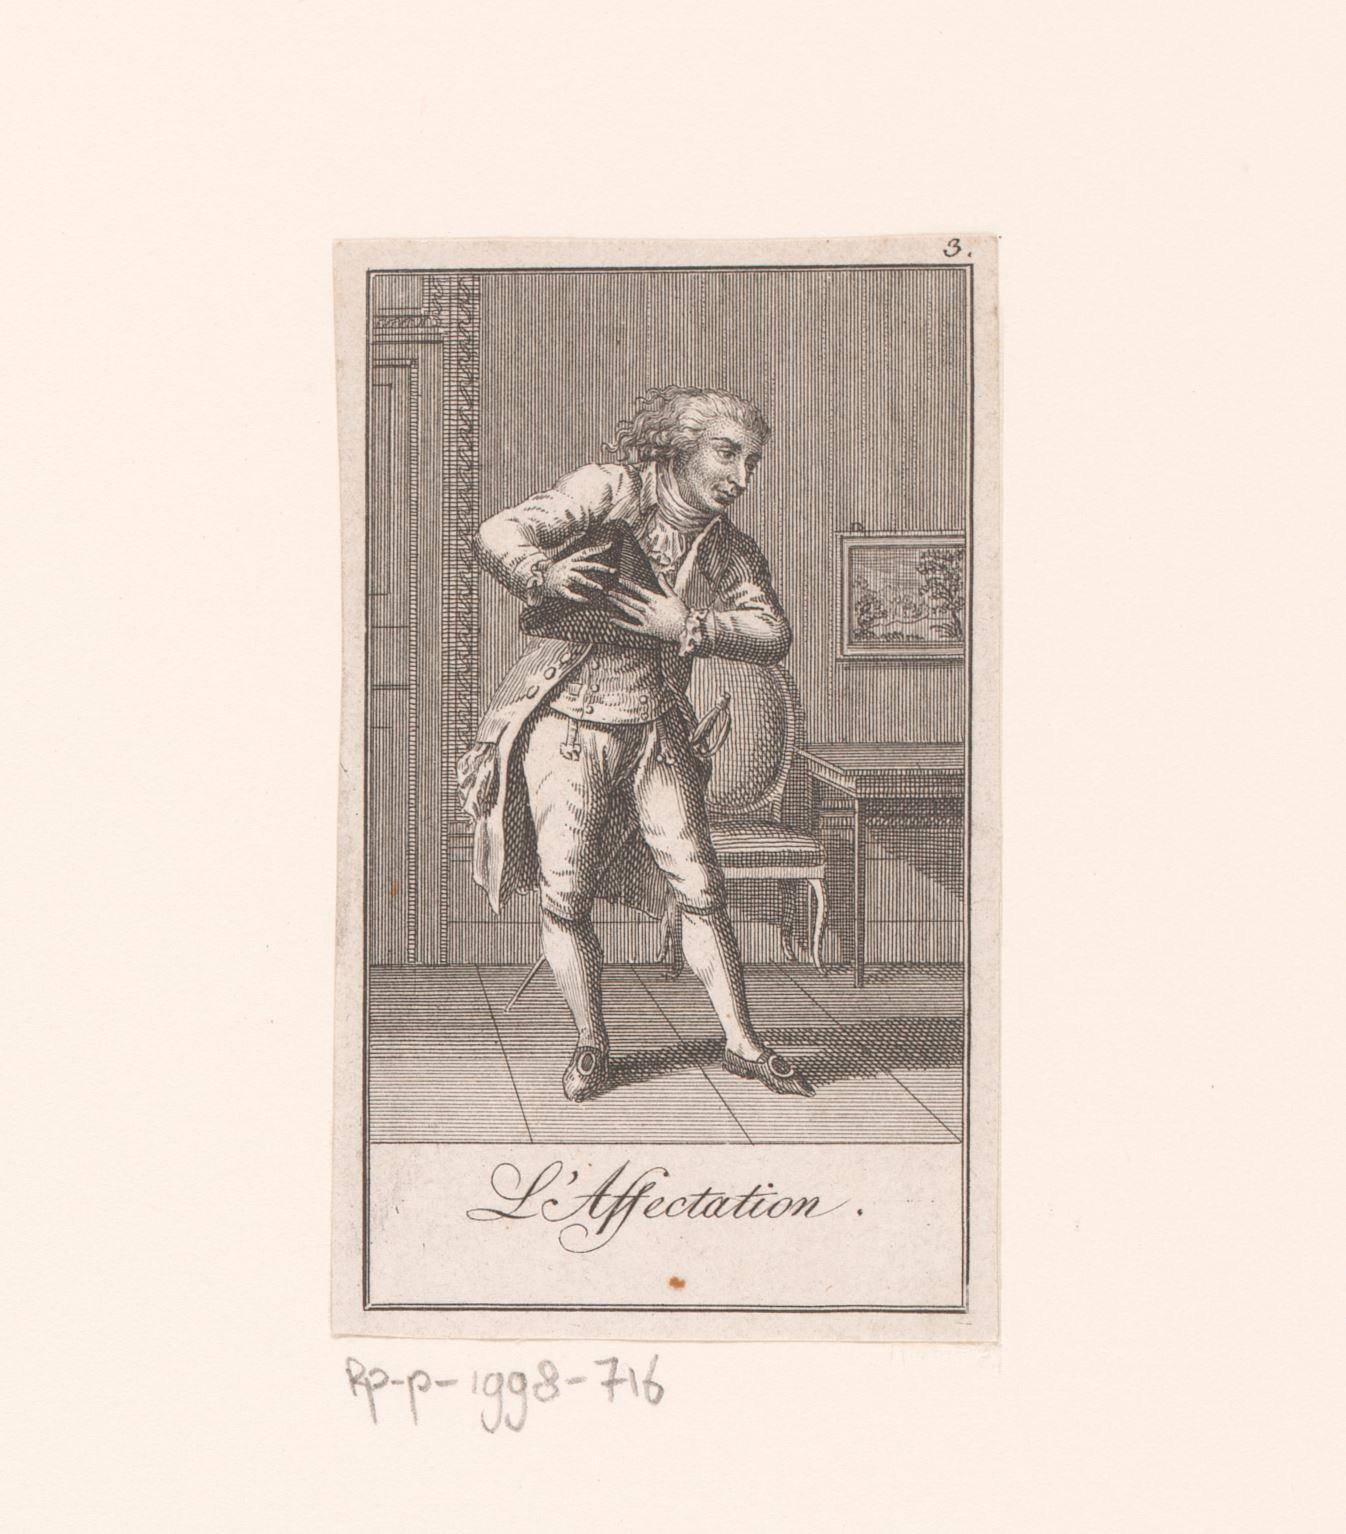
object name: print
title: Onoprechte man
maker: karl heinrich grünler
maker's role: print maker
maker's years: 1761-1823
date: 1771-1810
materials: paper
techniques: etching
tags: affectation, mannerism, baring the head, lifting one's hat, adult man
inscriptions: collector's mark: Lugt 2228